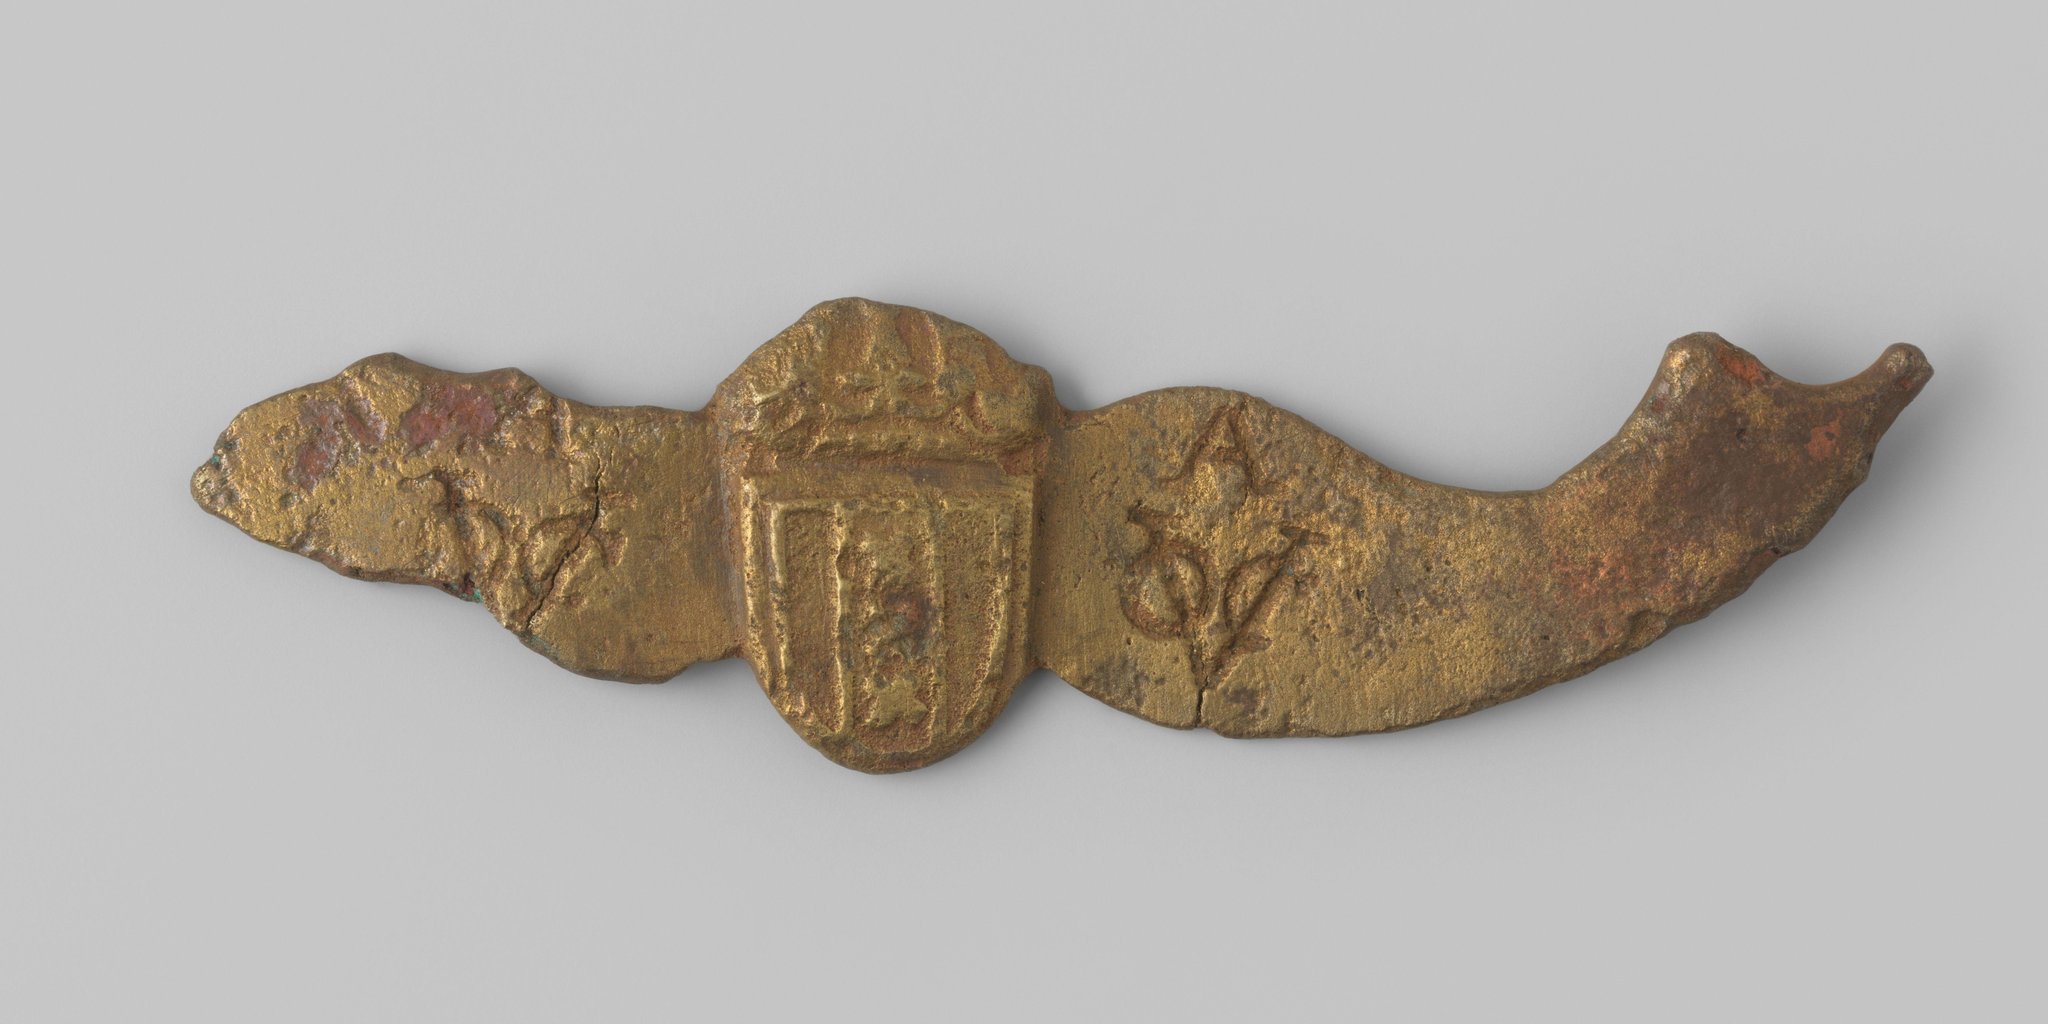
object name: musket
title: Fragment schroefplaat van een musket uit het wrak van de Oost-Indiëvaarder Hollandia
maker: Anonymous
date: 1700-1743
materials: copper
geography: netherlands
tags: verenigde oostindische compagnie, hollandia (schip), annet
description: Fragm, id. NG 1978-74H986 or NG 1980-27H3069, eyes broken off, side plate.